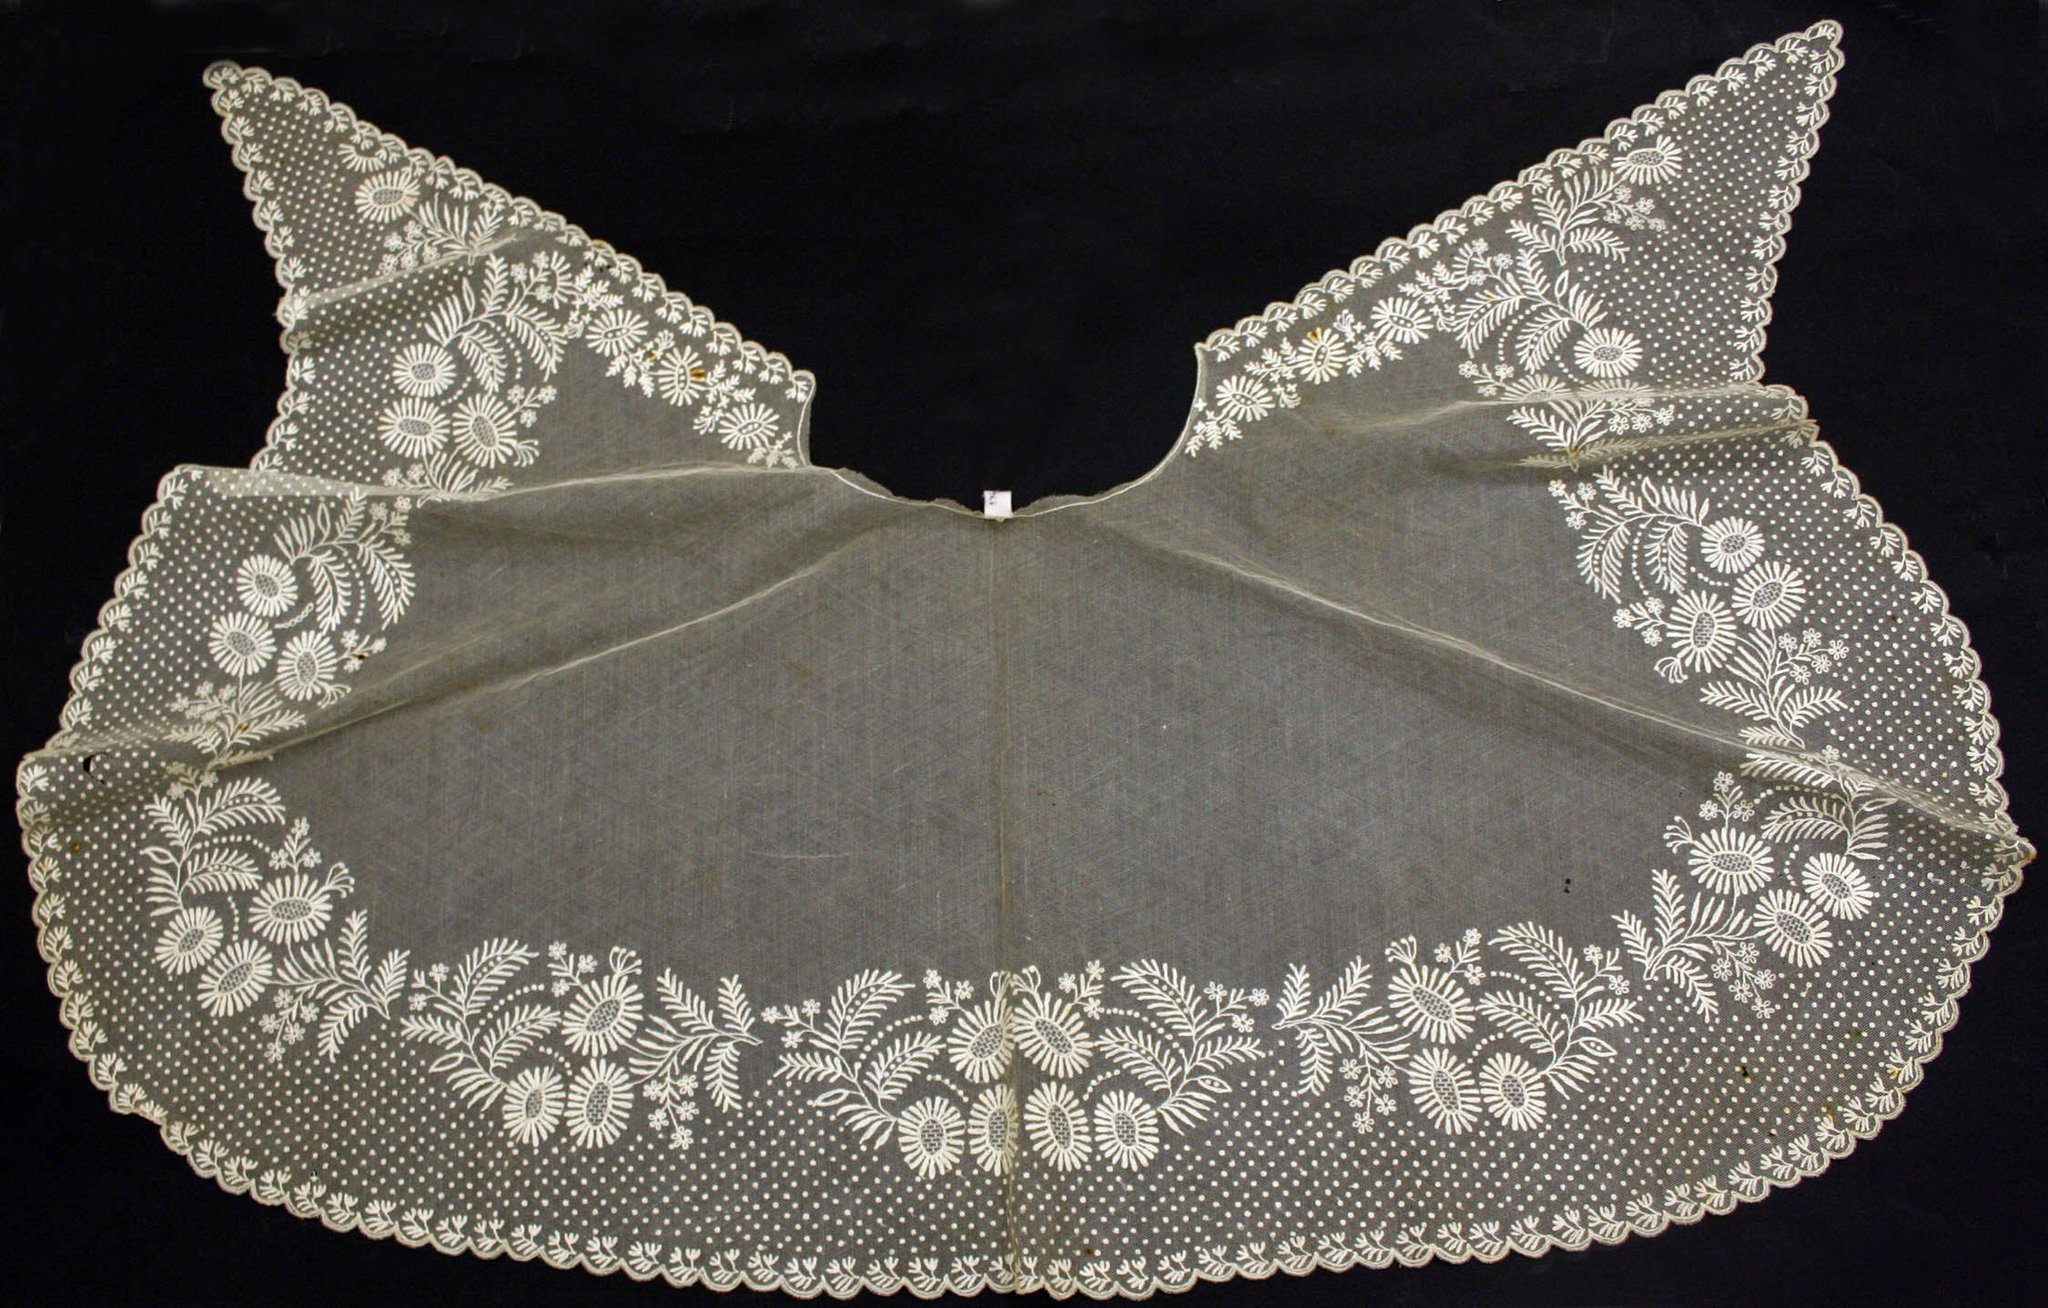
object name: pelerine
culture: american or european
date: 1830-1836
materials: cotton